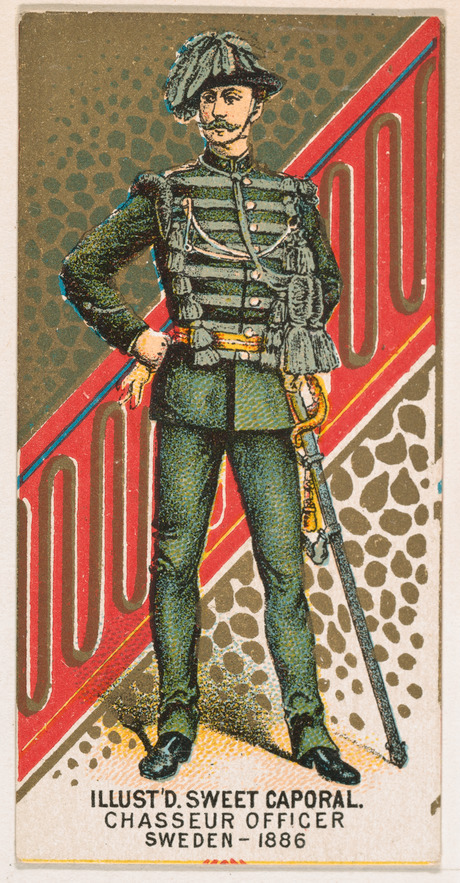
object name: print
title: Chasseur, Officer, Sweden, 1886, from the Military Series (N224) issued by Kinney Tobacco Company to promote Sweet Caporal Cigarettes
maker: kinney brothers tobacco company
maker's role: publisher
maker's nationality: american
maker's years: 1869-2011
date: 1888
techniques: color lithograph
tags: military,swords,men